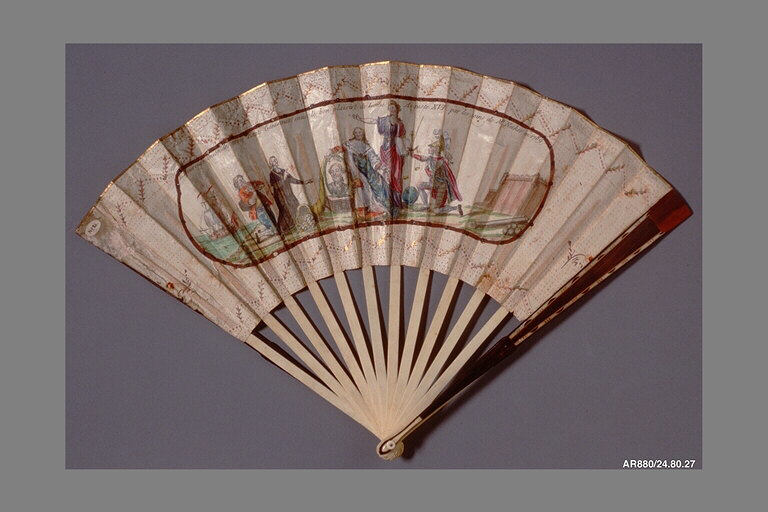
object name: fan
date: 1789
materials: bone, paper, wood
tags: men,women